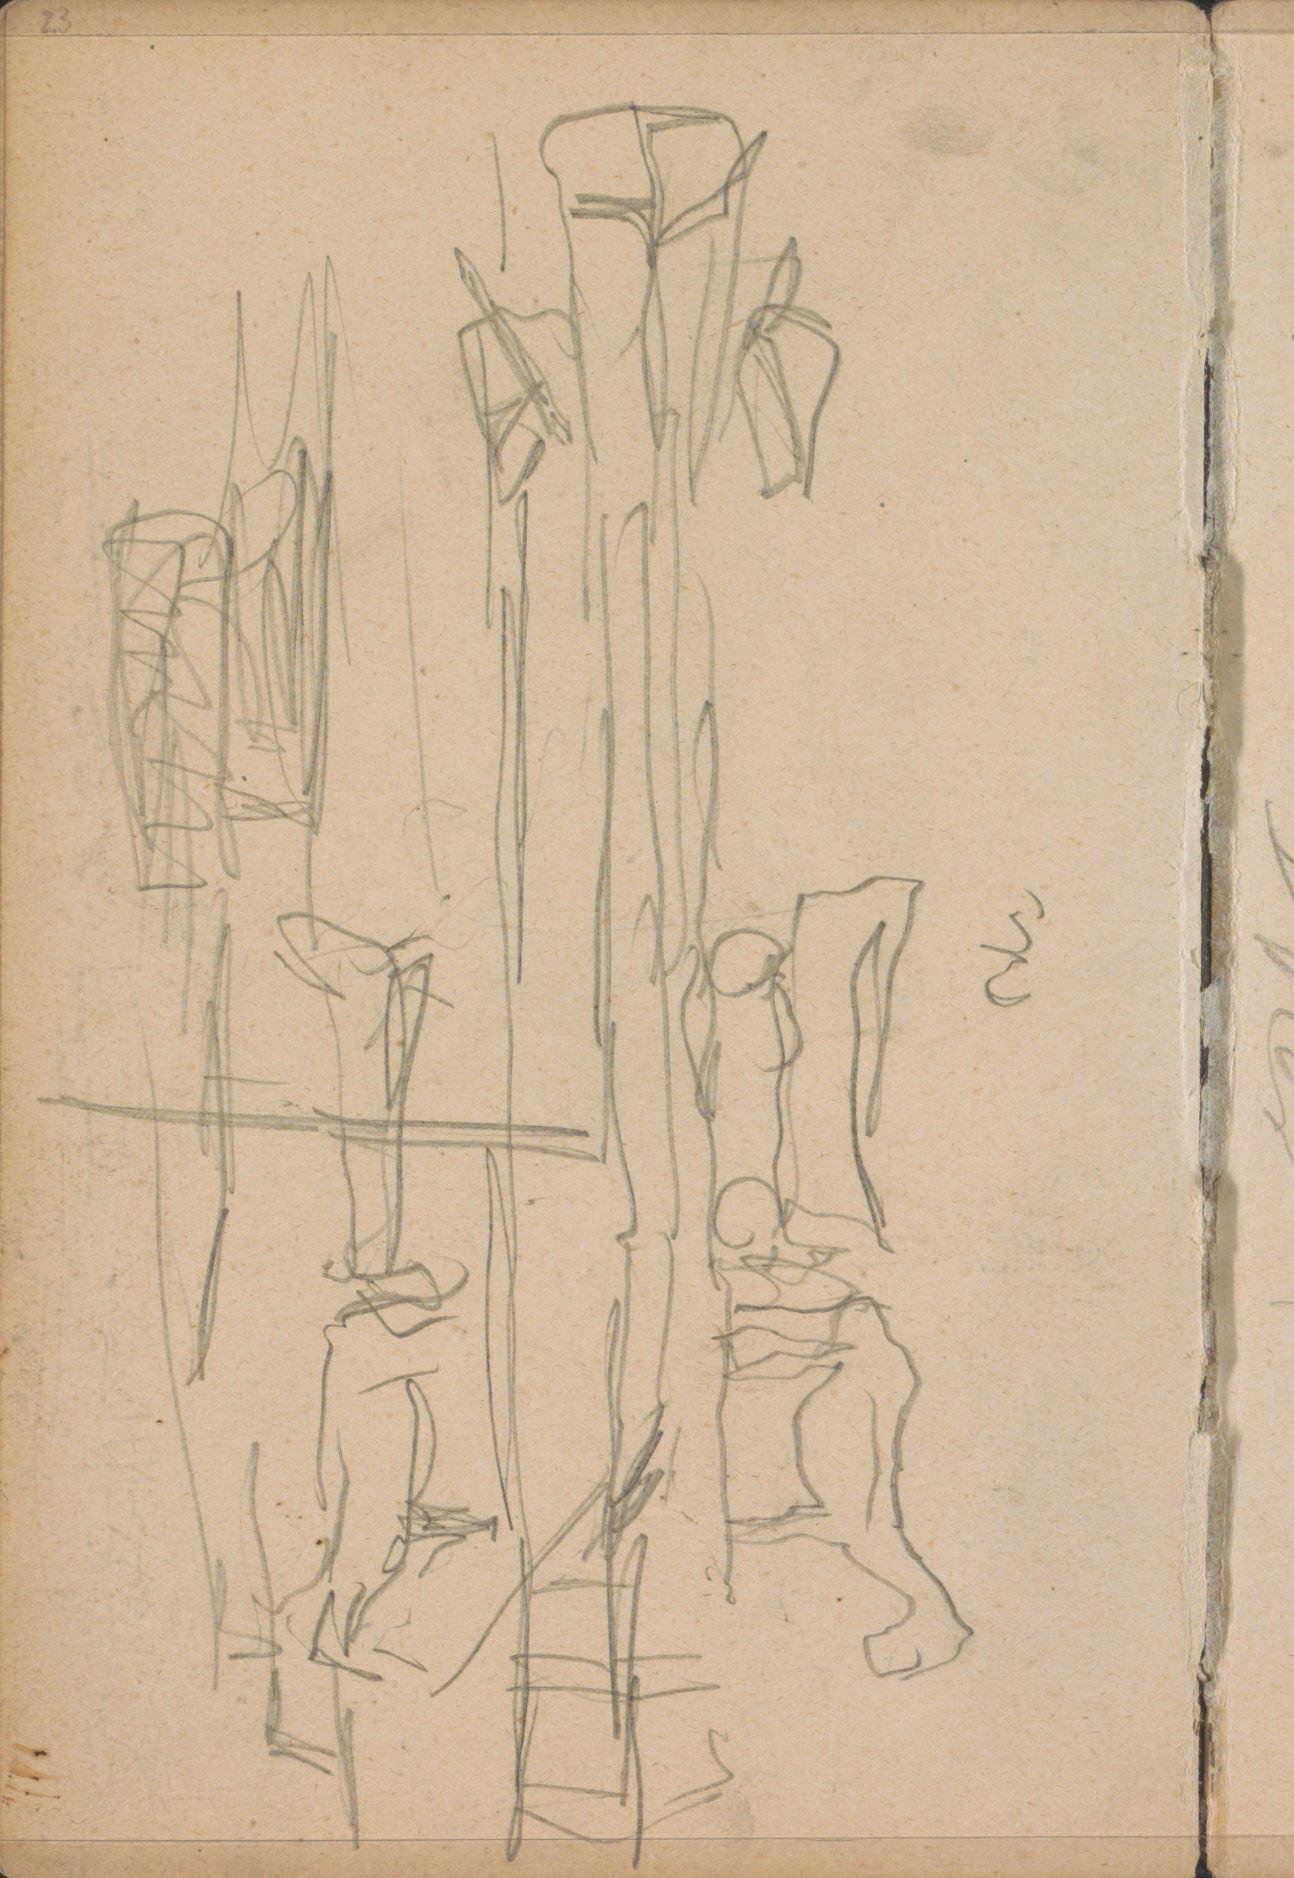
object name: sketchbook leaf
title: Paard-en-wagen, mogelijk bij boten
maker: george hendrik breitner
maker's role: draughtsman, painter, print maker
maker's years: 1857-1923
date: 1886-1908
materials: paper, pencil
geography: amsterdam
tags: landscapes with waters, waterscapes, seascapes (in the temperate zone), ships (in general), horse, (farm) wagon, freight wagon, cart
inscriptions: kleurnotitie, handgeschreven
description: Paard-en-wagen, mogelijk weerspiegeld in het water met boten. Pagina 23 uit een schetsboek met 46 bladen vervaardigd te Amsterdam, Haarlem en Antwerpen.